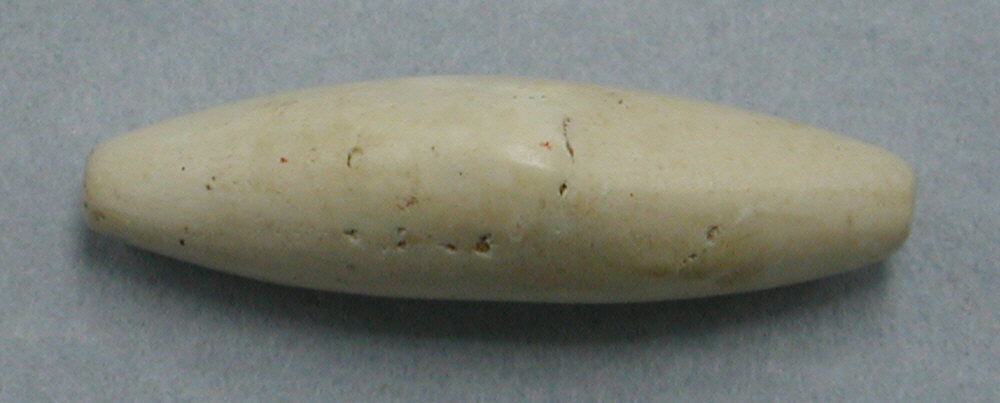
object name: ritual stone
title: Polishing Stone (pulidor)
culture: mexican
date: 1501-1600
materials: stone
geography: mexico